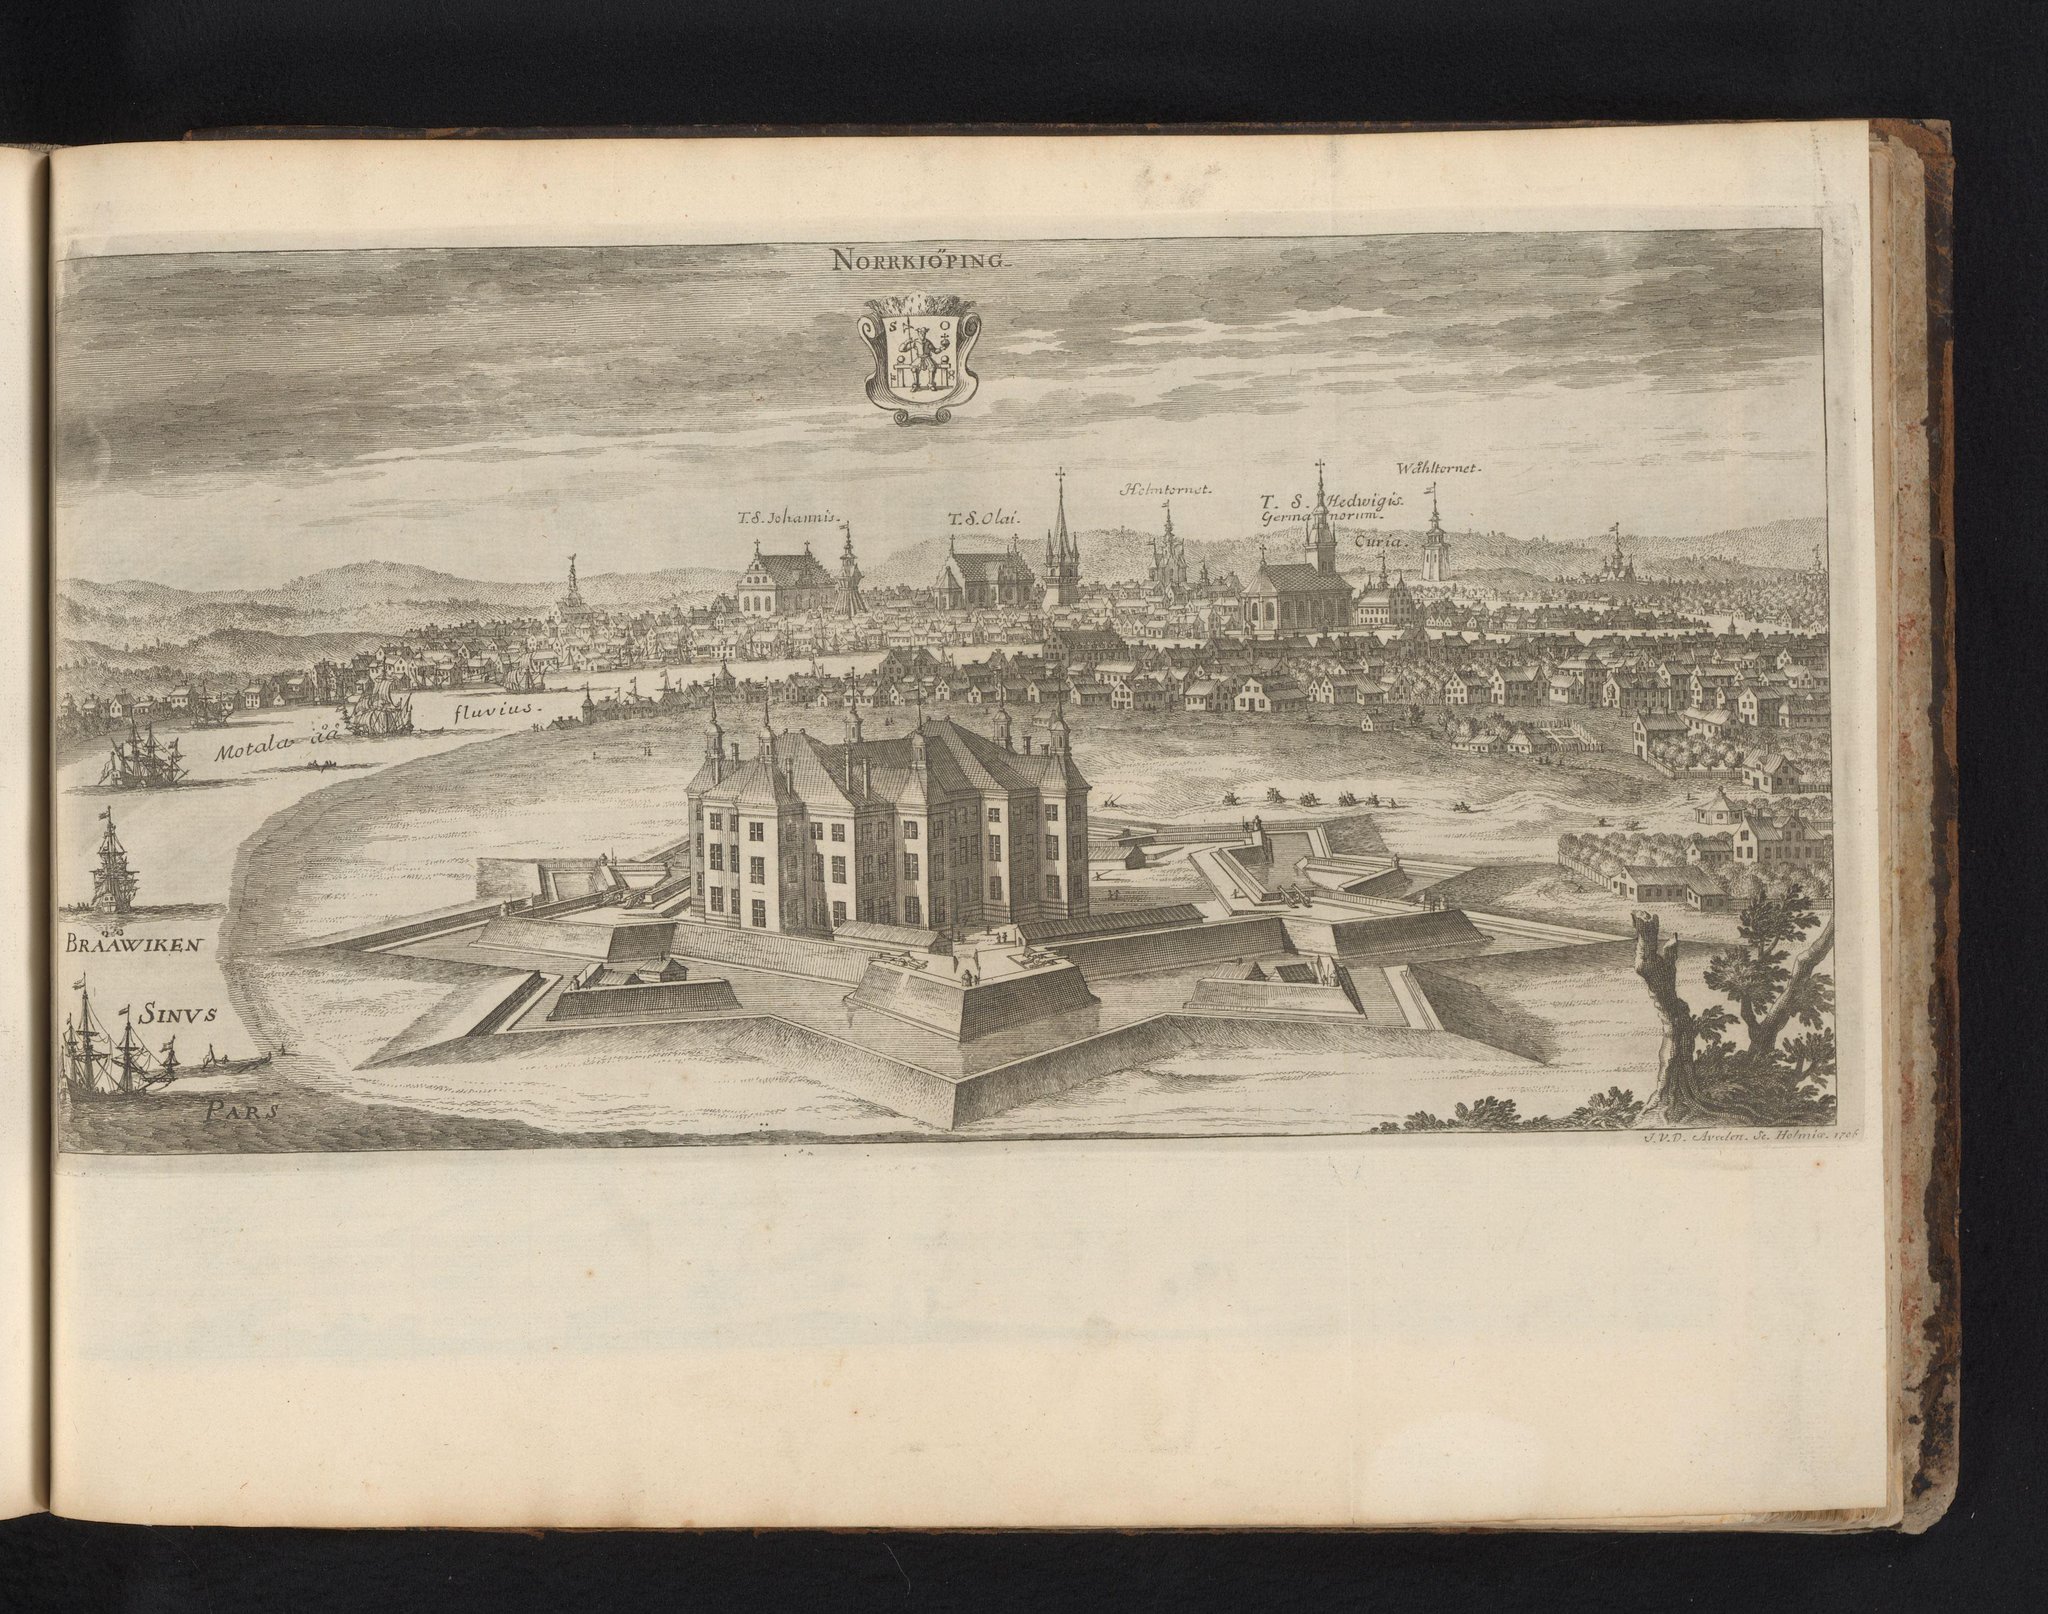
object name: print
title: Norrkiöping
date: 1706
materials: paper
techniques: etching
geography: stockholm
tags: city-view in general; 'veduta'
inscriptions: date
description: Kungliga Biblioteket, 'Suecia': http://www.kb.se/samlingarna/Kartor-bilder/Suecia-antiqua/ (geraadpleegd november 2016).